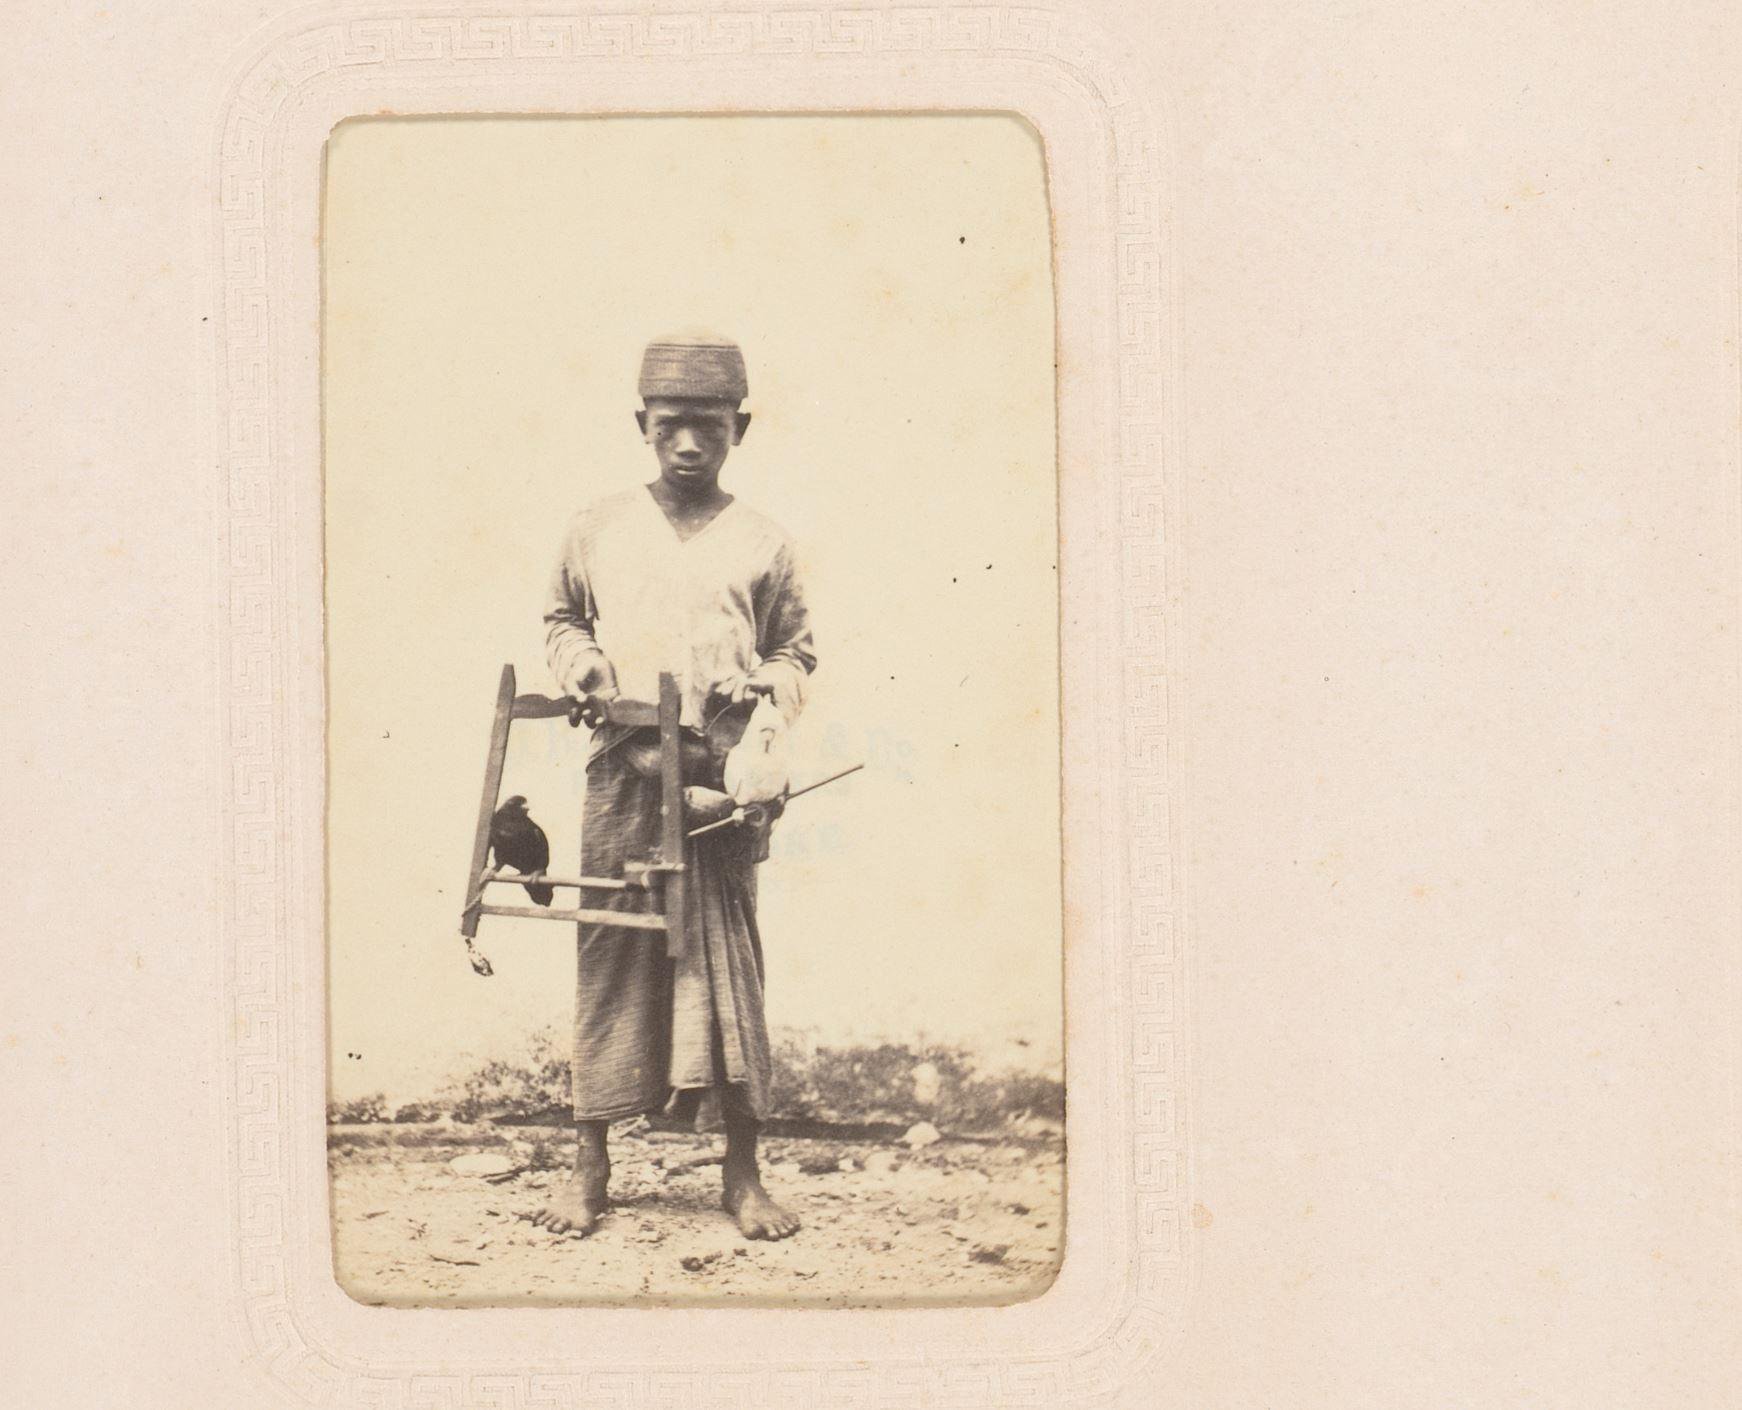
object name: photograph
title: Portret van een Maleisische parkietverkoper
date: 1867-1880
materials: cardboard, photographic support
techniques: albumen print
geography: singapore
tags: historical persons, merchant, salesman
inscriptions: annotation: ‘1 Mal: Parakietverkaufer/ Singapore’, number: ‘19’